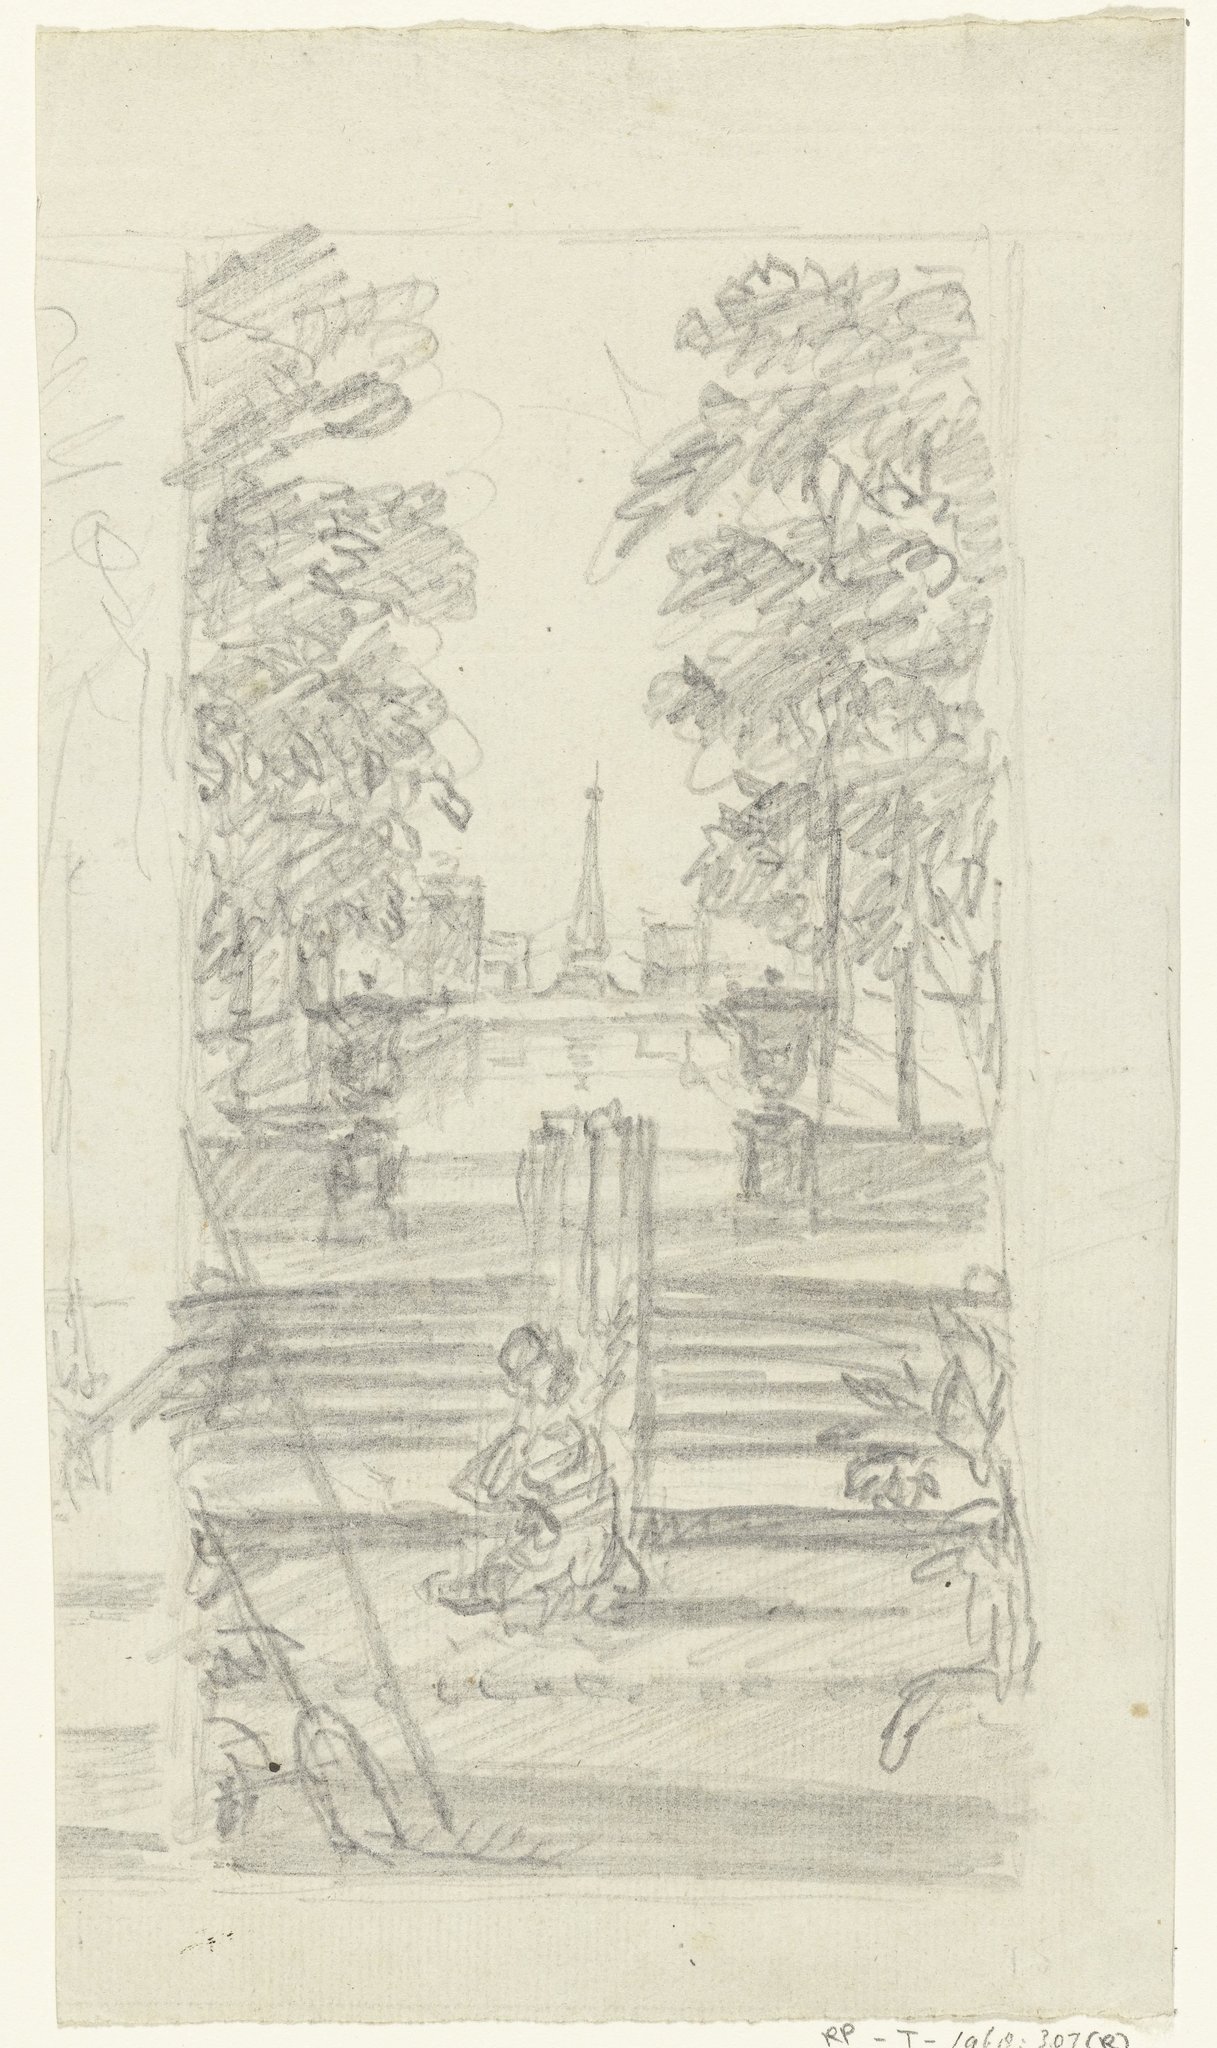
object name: design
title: Tuin met vijver, op de voorgrond tuingereedschap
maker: dionys van nijmegen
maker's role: draughtsman, painter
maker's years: 1705-1798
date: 1715-1798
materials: paper, pencil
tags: garden